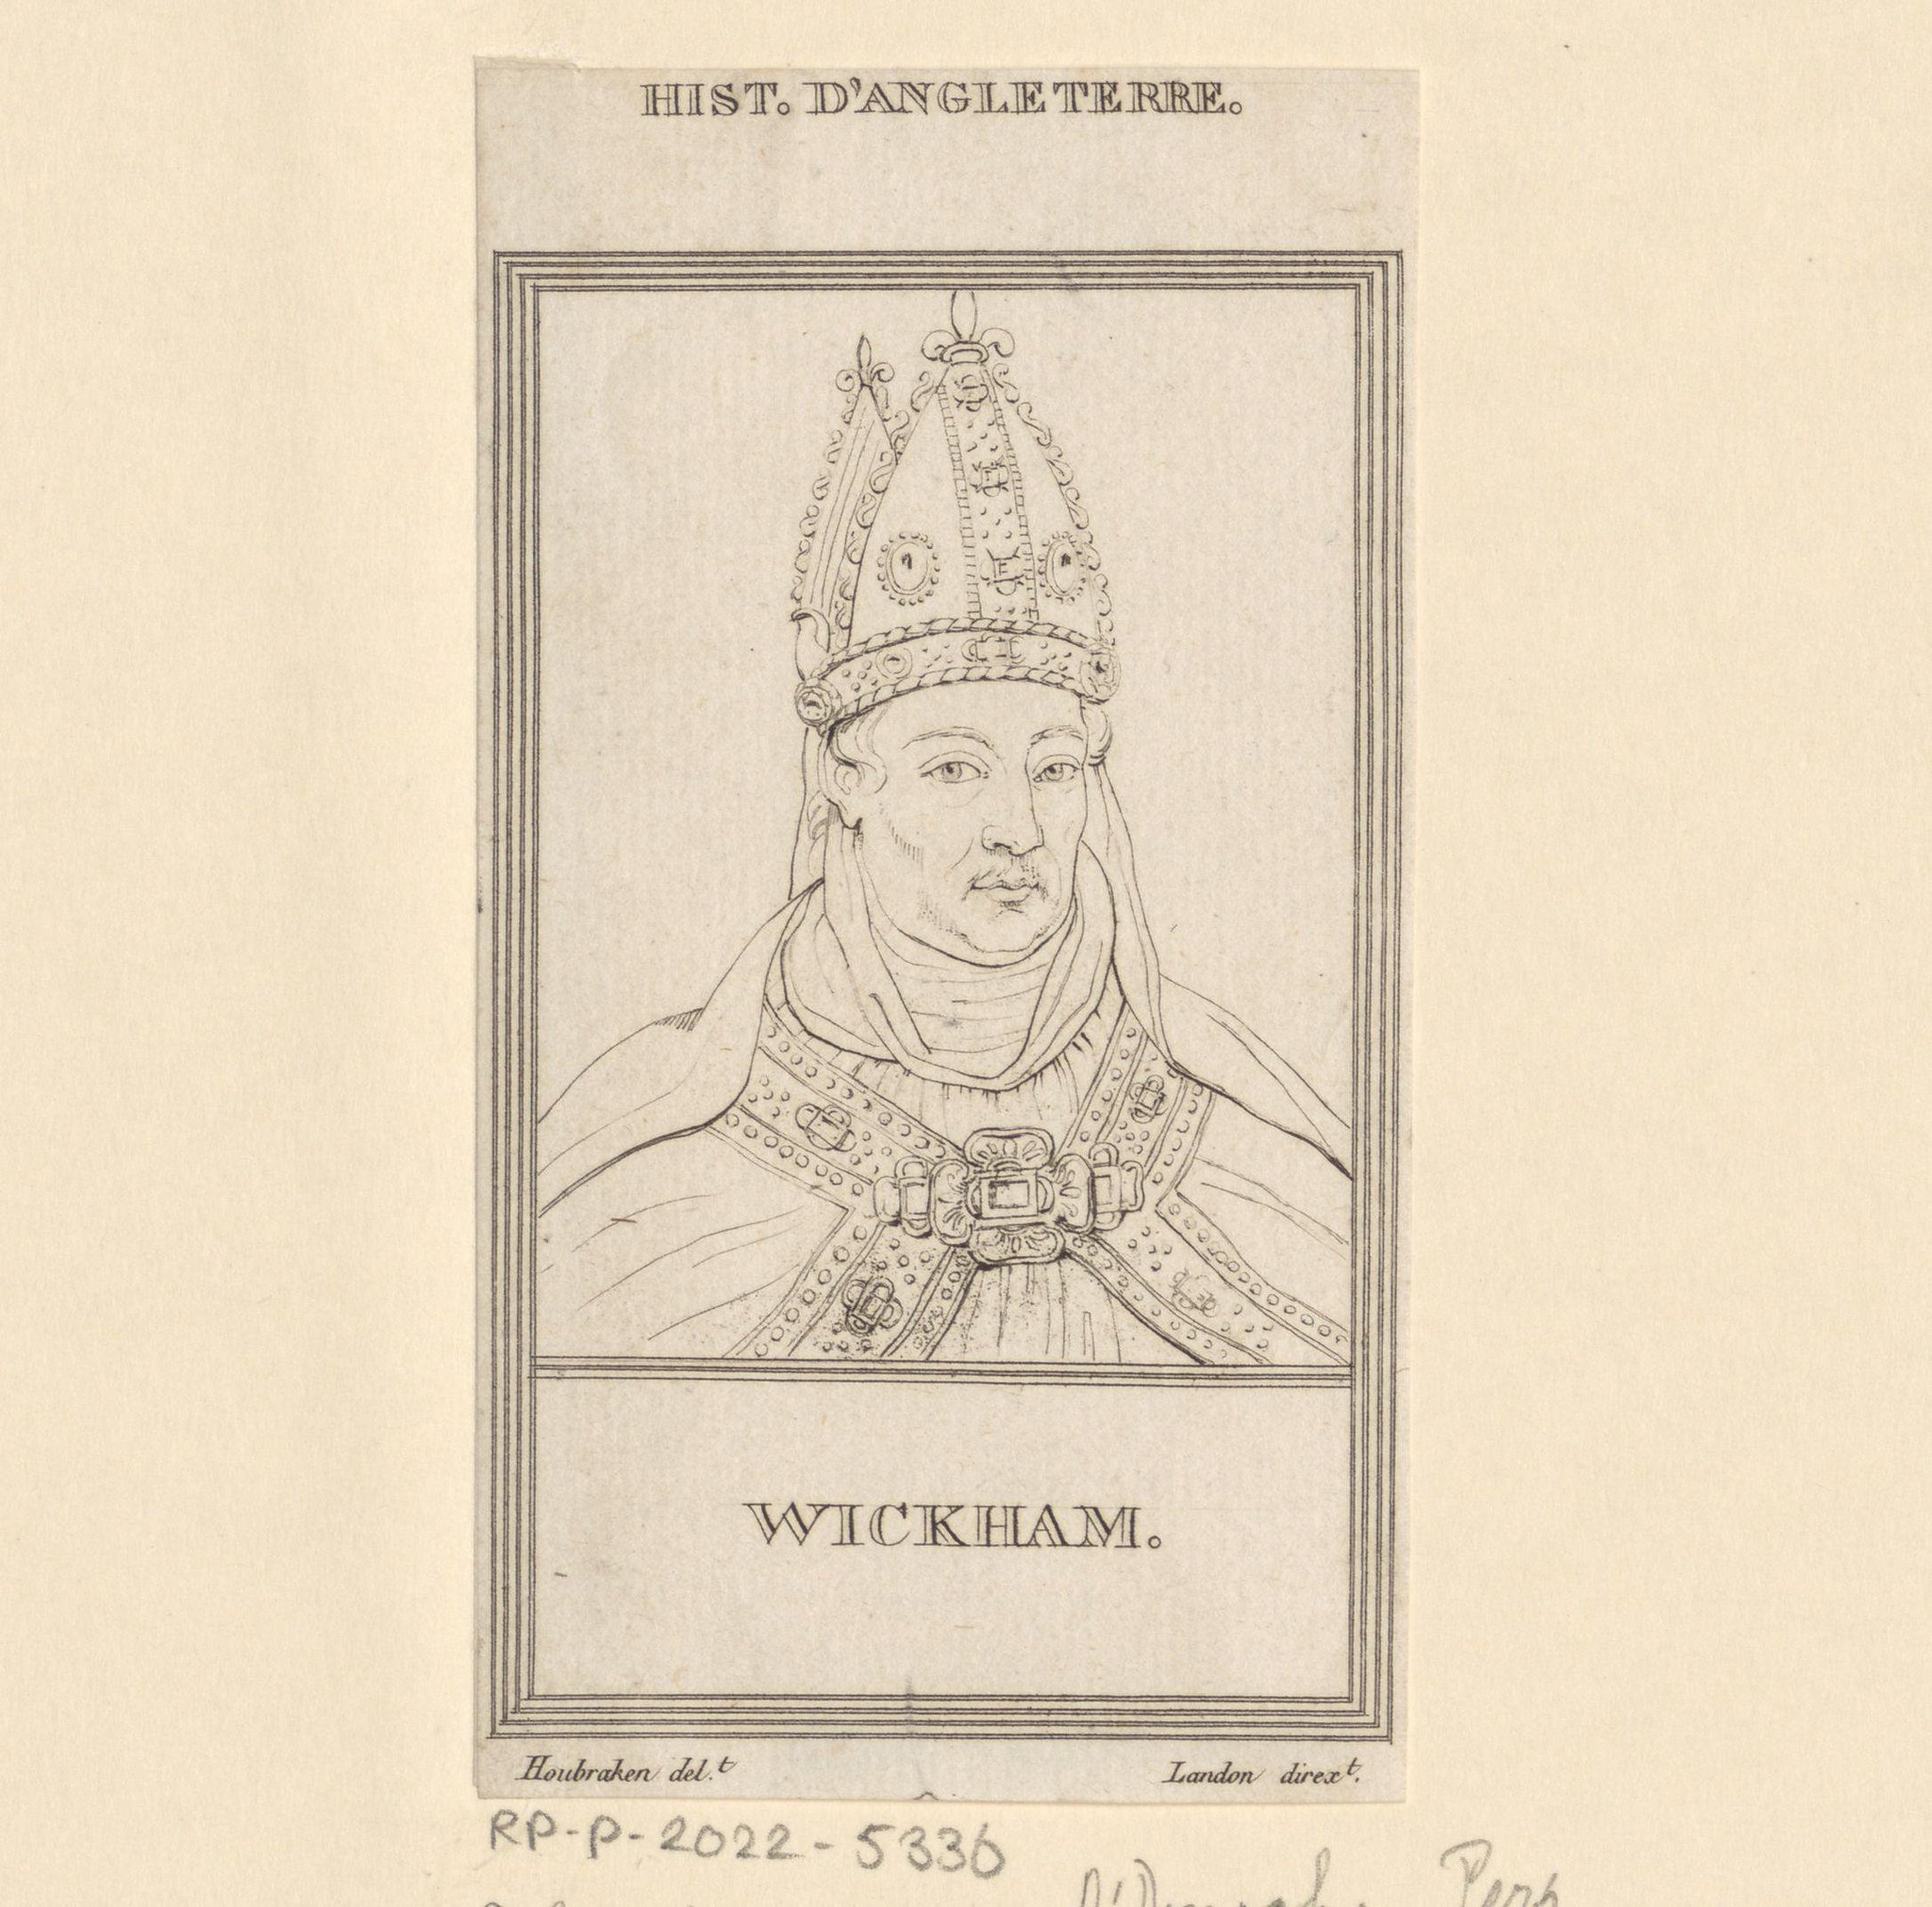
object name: print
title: Portret van William Wickham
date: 1808-1810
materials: paper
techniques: etching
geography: france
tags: archbishop, bishop, etc. (roman catholic), historical persons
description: Prent waarschijnlijk uit: Landon, Charles Paul. Galerie historique des hommes les plus célèbres (...). Parijs: Imprimerie des Annales du Musée, 1808, dl. 12. Prent ook gebruikt in: Barjaud, Jean Baptist Benoit en Charles Paul Landon. Description de Londres et de ses édifices (...). Parijs: Charles Paul Landon, 1810.